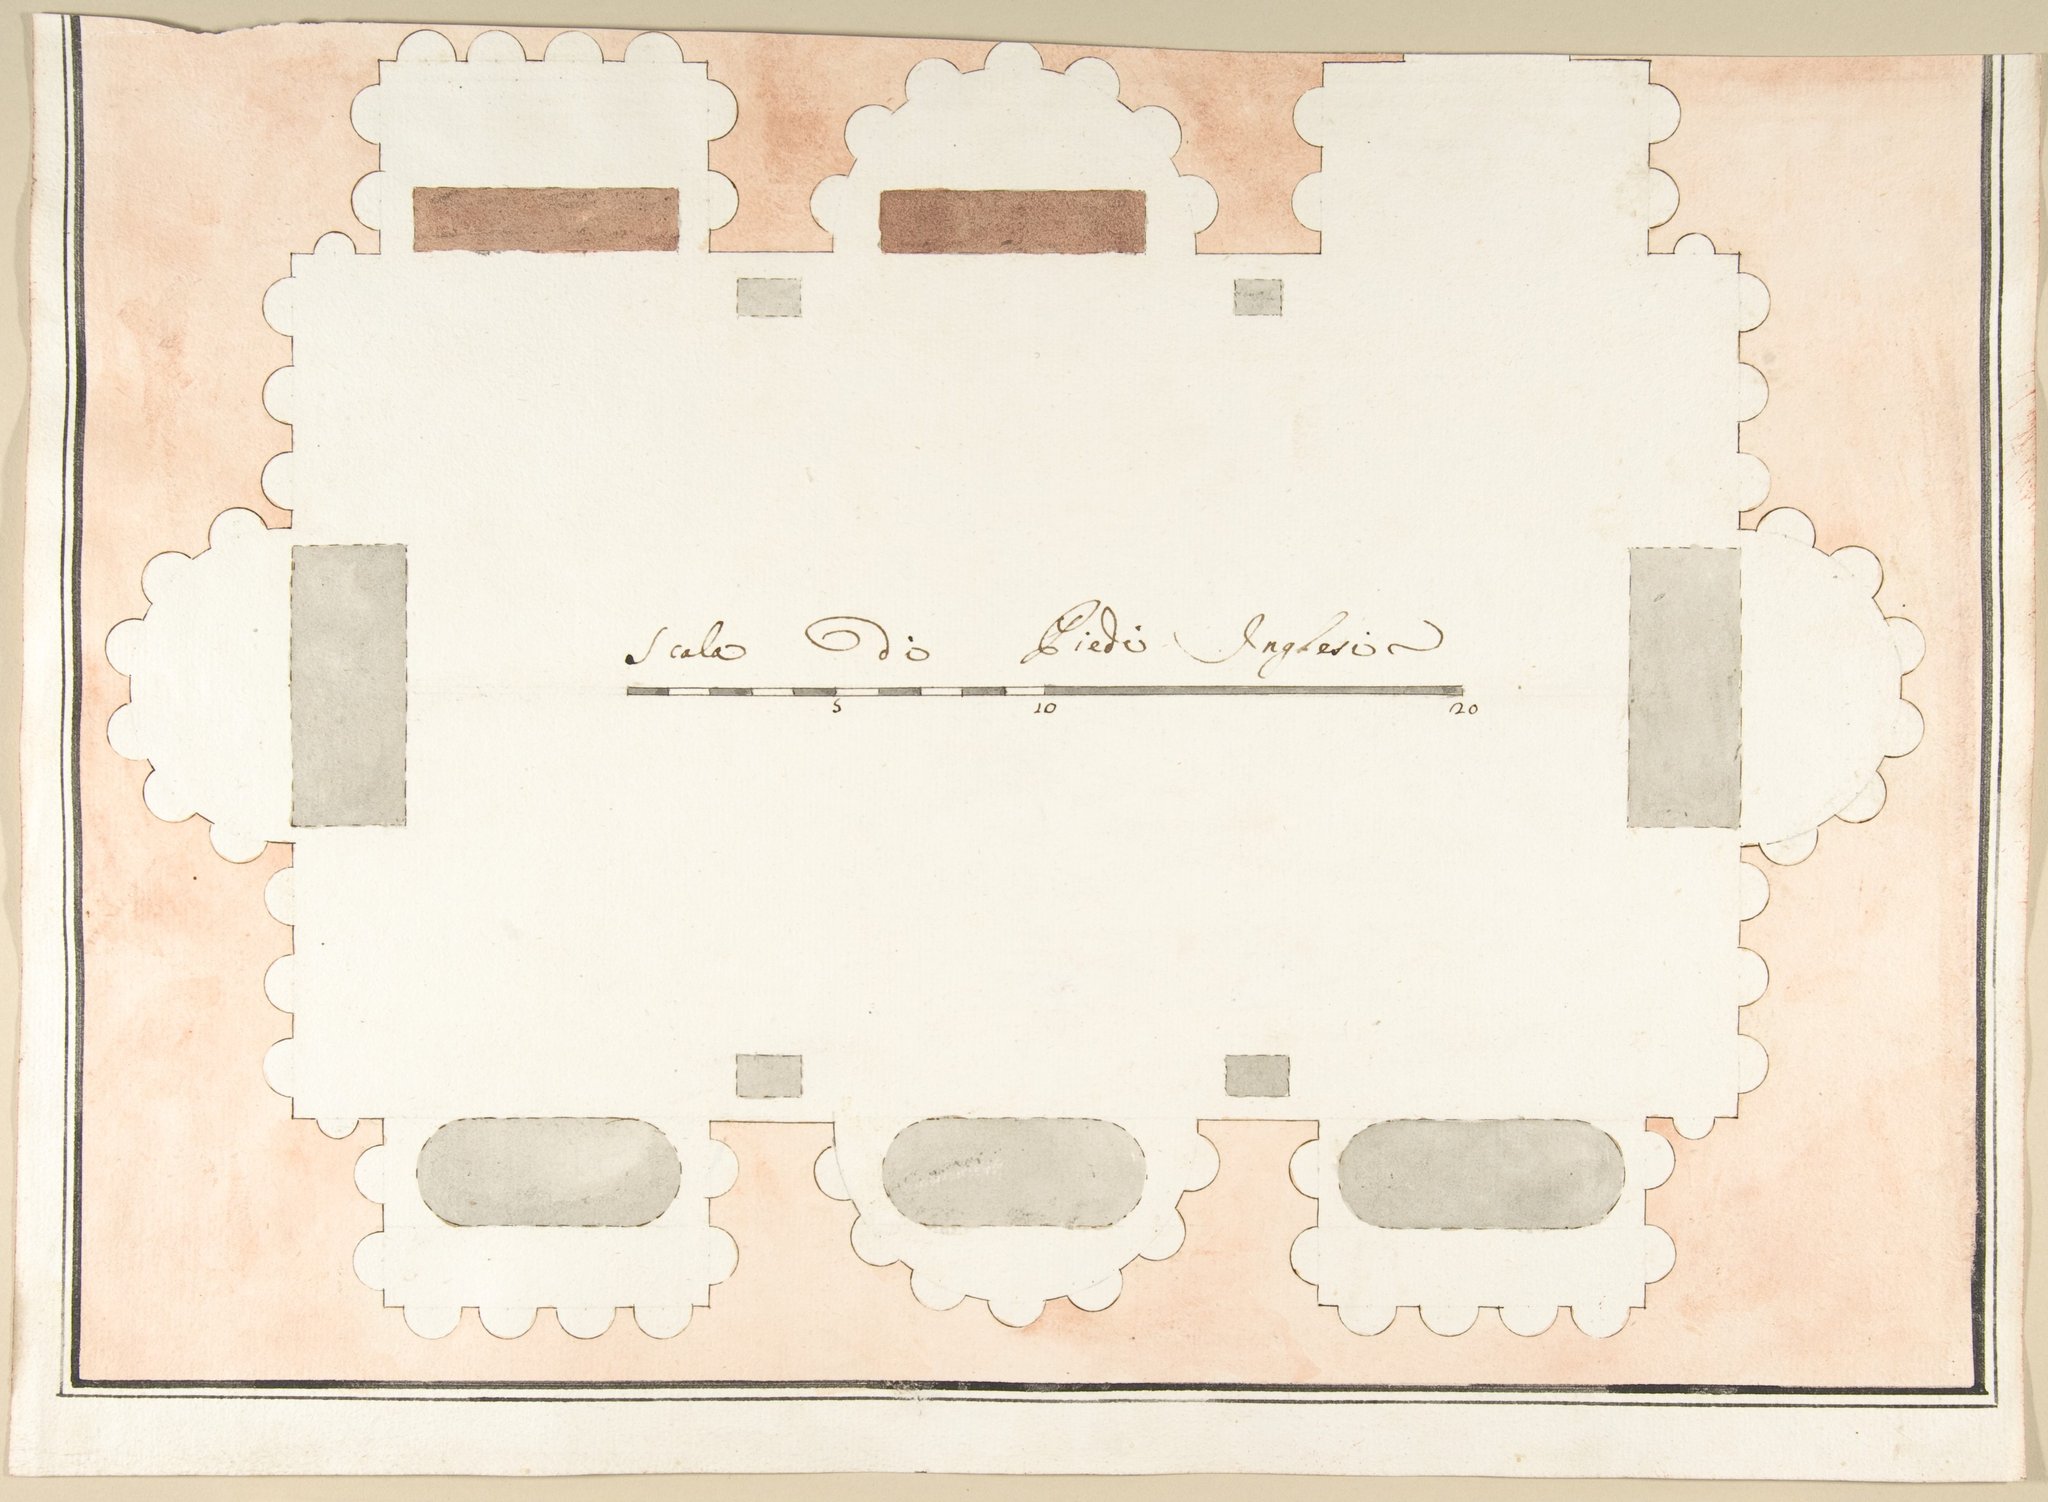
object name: drawing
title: Plan of a Columbarium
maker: pietro paolo coccetti (cocchetti)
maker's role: artist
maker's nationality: italian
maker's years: 1710-1727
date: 1710-1727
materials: graphite, ink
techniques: brush, pen, wash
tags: architecture